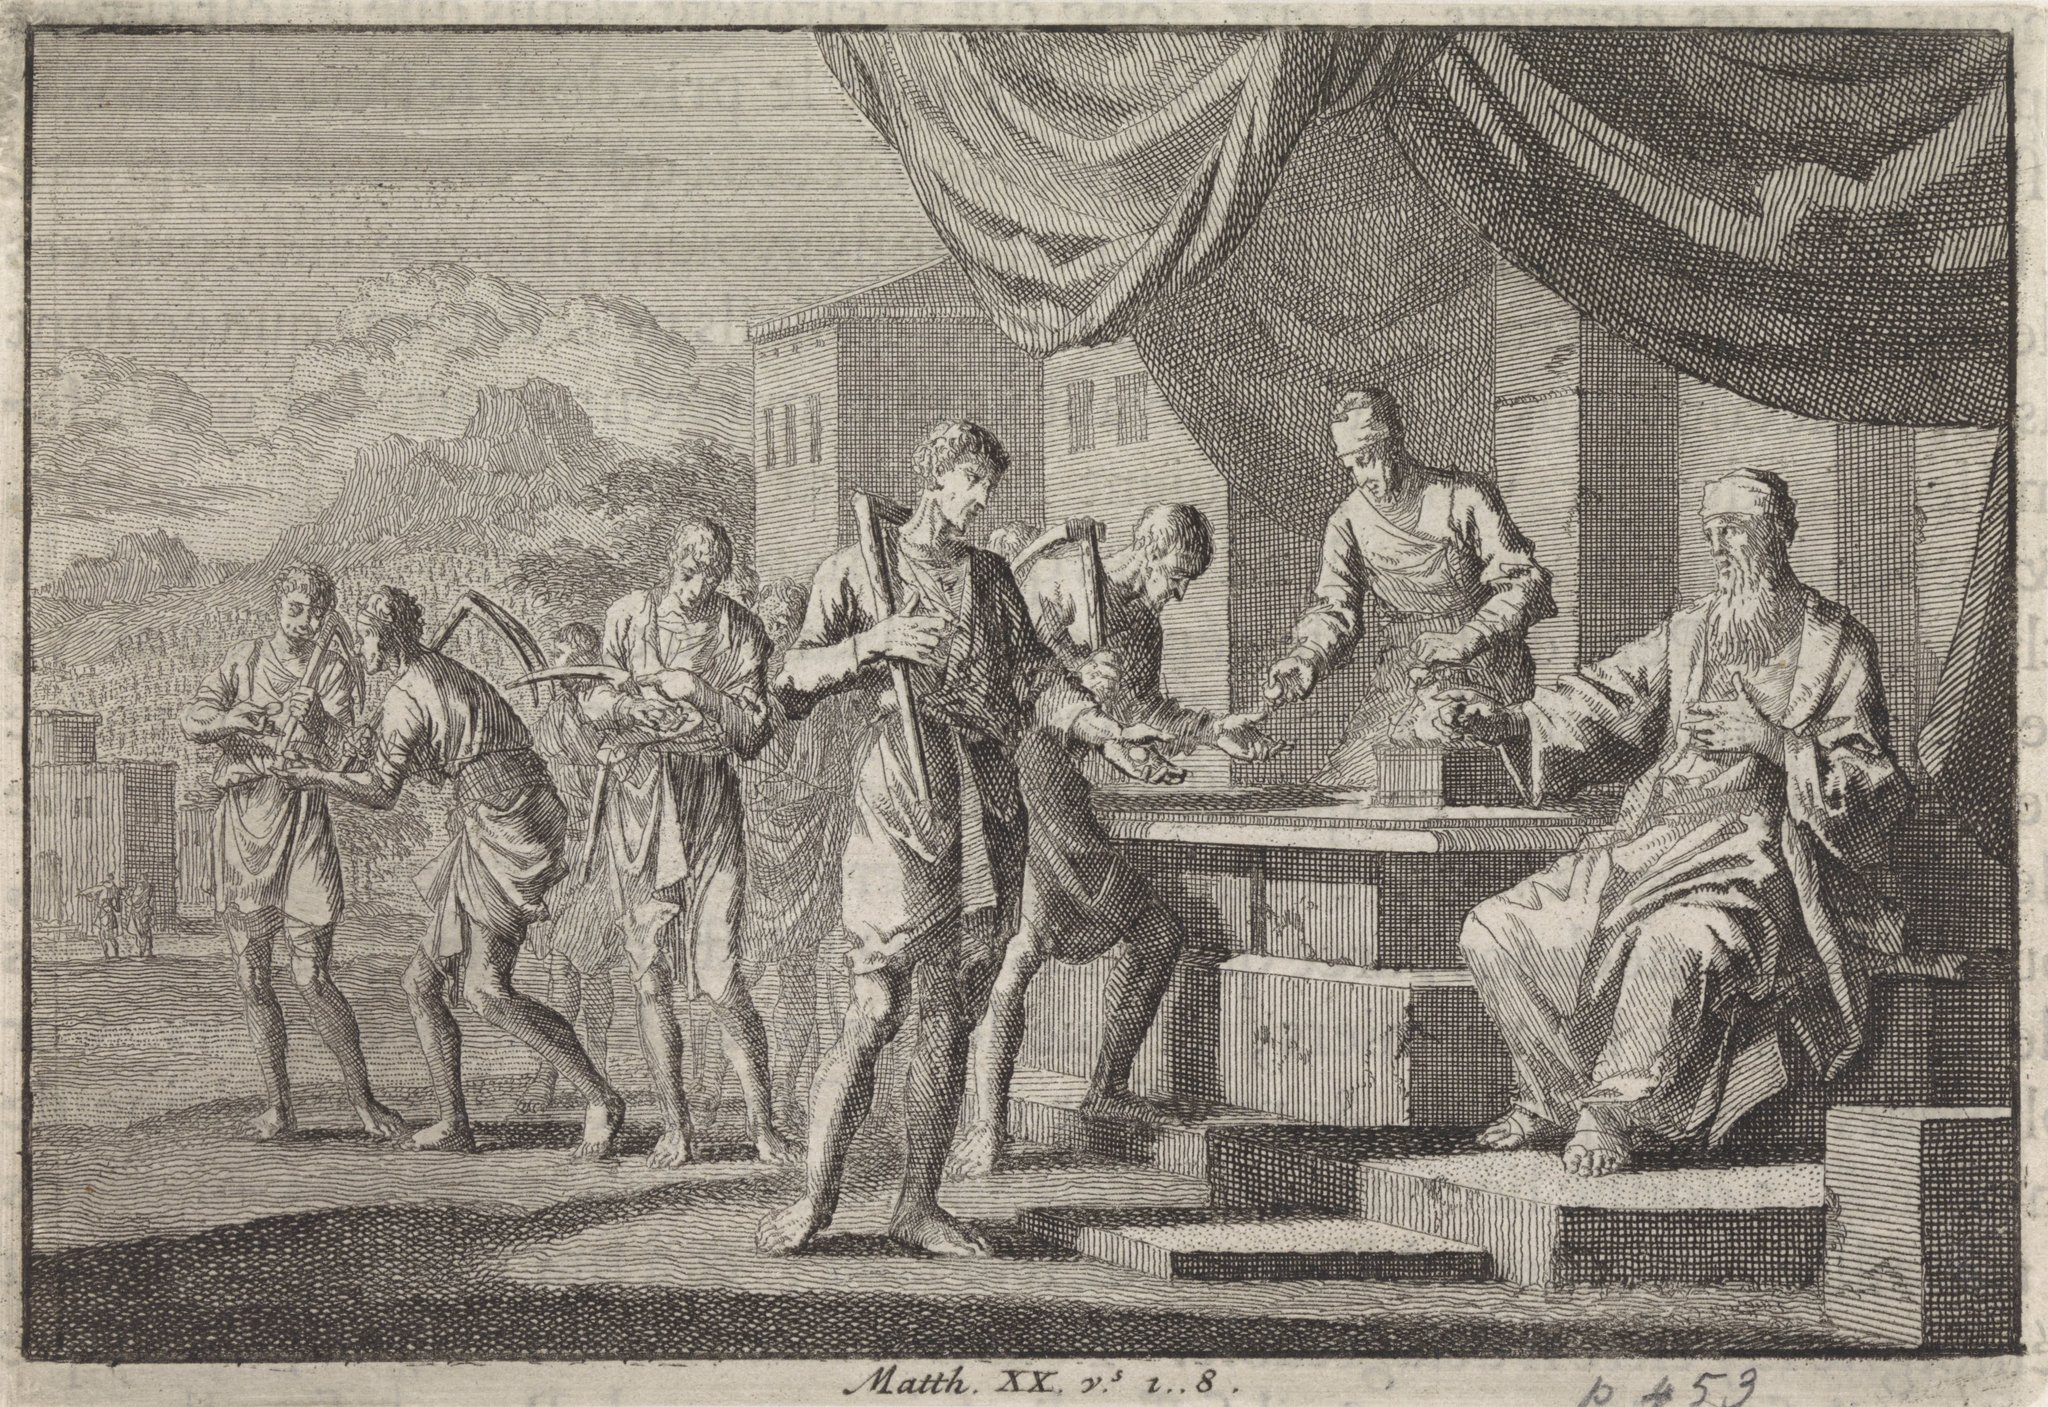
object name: print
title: Gelijkenis van de arbeiders in de wijngaard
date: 1703-1762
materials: paper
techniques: etching, letterpress printing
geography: amsterdam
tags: at the end of the day the lord pays all the labourers equally; those that worked all day object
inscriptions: collector's mark: Lugt 2228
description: De prent komt een eerste keer voor als boekillustratie voor David Martin. Historie des Ouden en Nieuwen Testaments. Amsterdam, Pieter Mortier, 1703. Deel II. De boekillustraties voor de Mortierbijbel hebben verschillende staten en kopieën, waarbij de chronologische volgorde moeilijk te achterhalen valt. Als boekillustraties werden ze bovendien herhaaldelijk opnieuw gebruikt voor andere boekwerken.